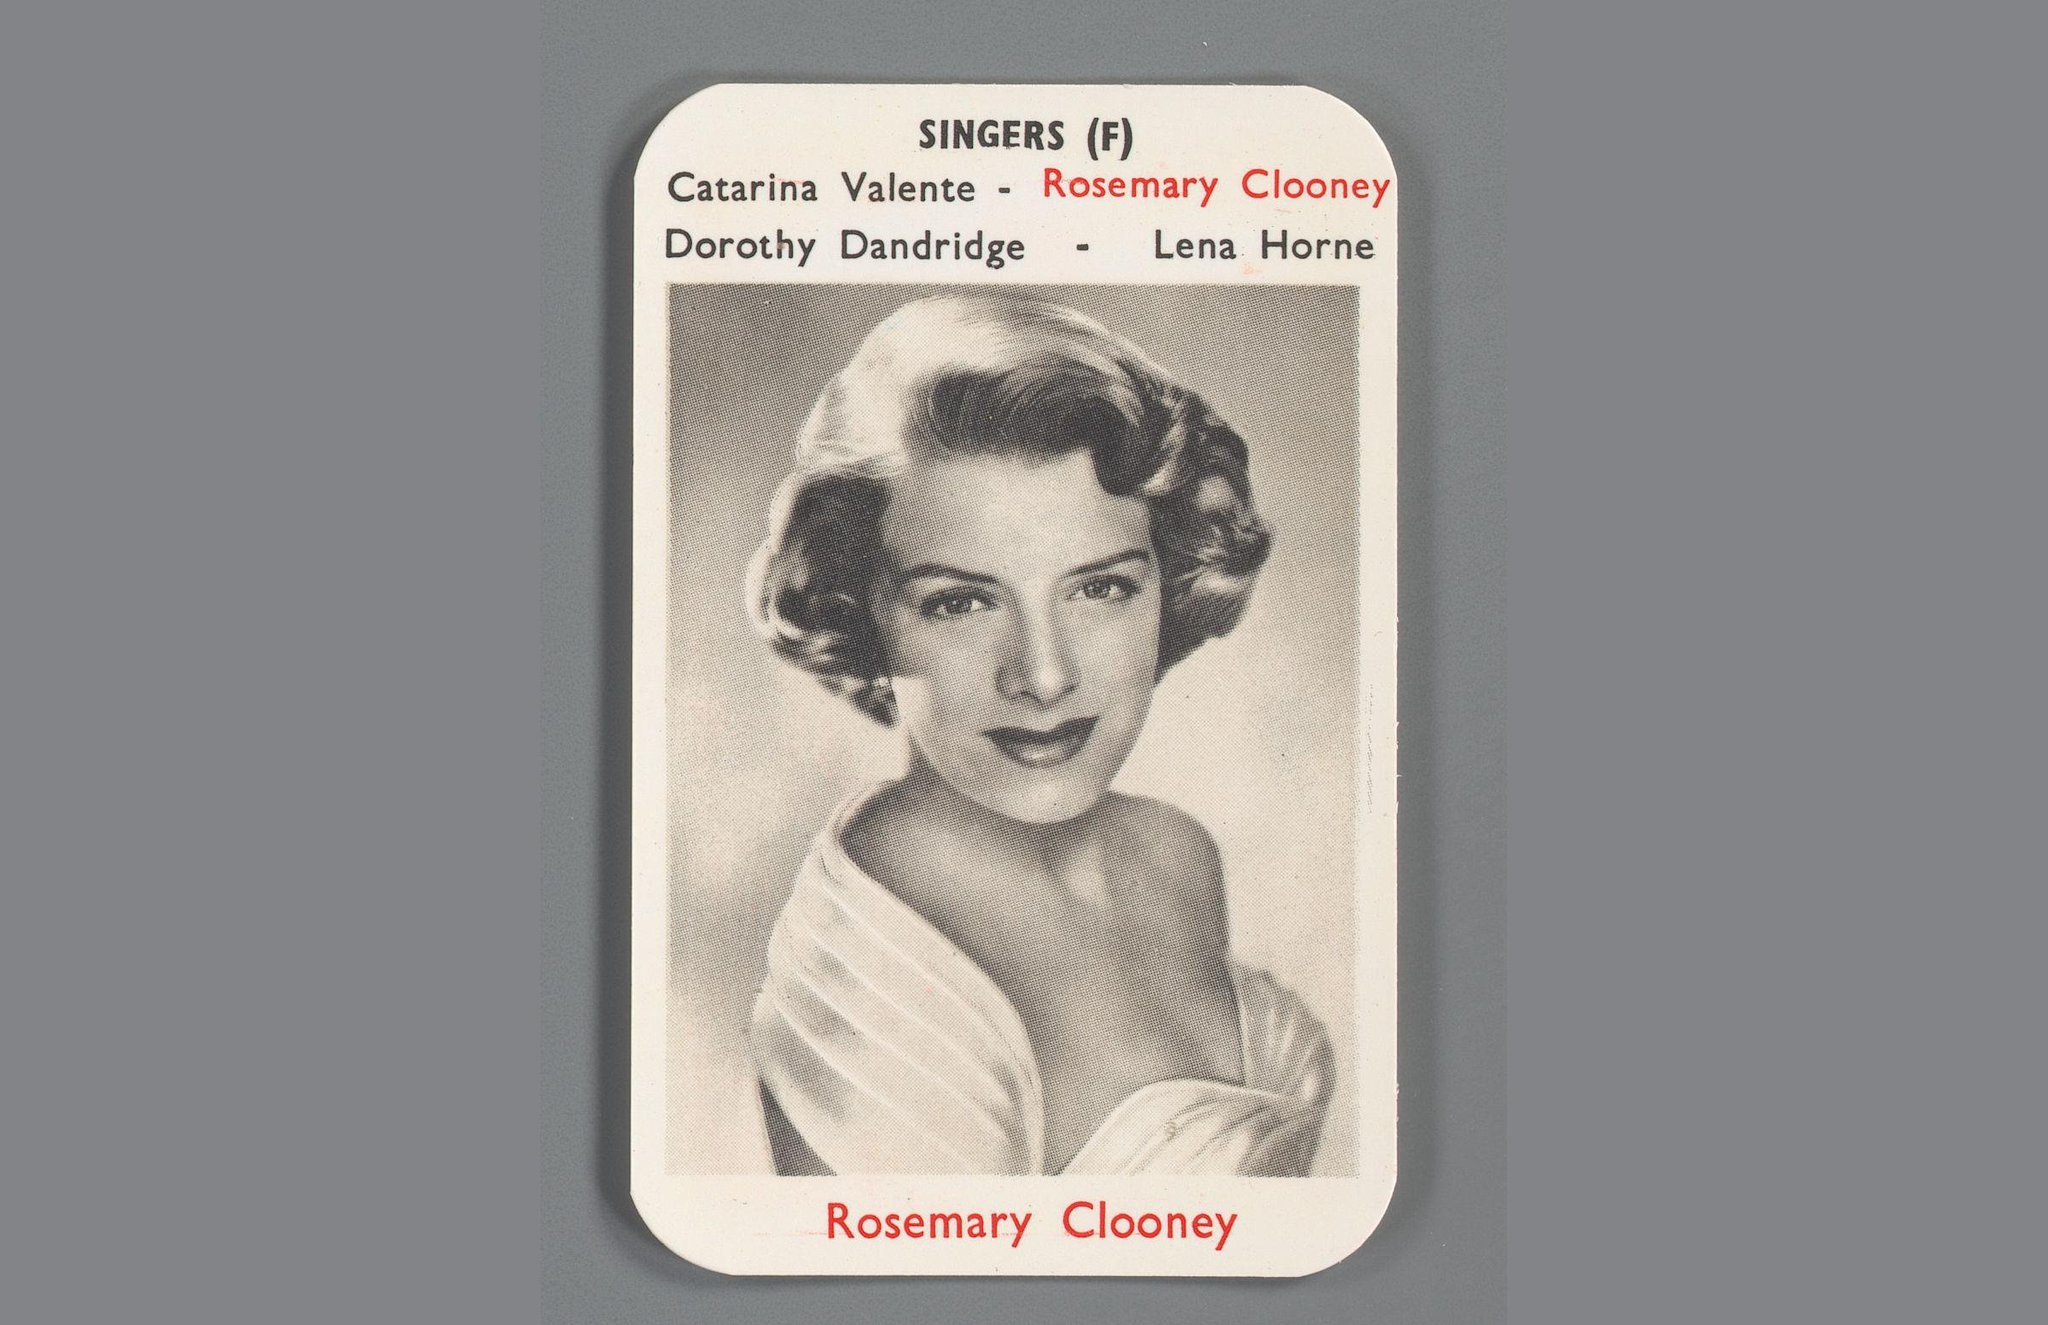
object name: photomechanical print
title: Portret van Rosemary Clooney; onderdeel van het kwartet Singers (F) uit een kwartetspel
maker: Anonymous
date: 1960-1970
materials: paper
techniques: autotype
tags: musician, portrait of a musician